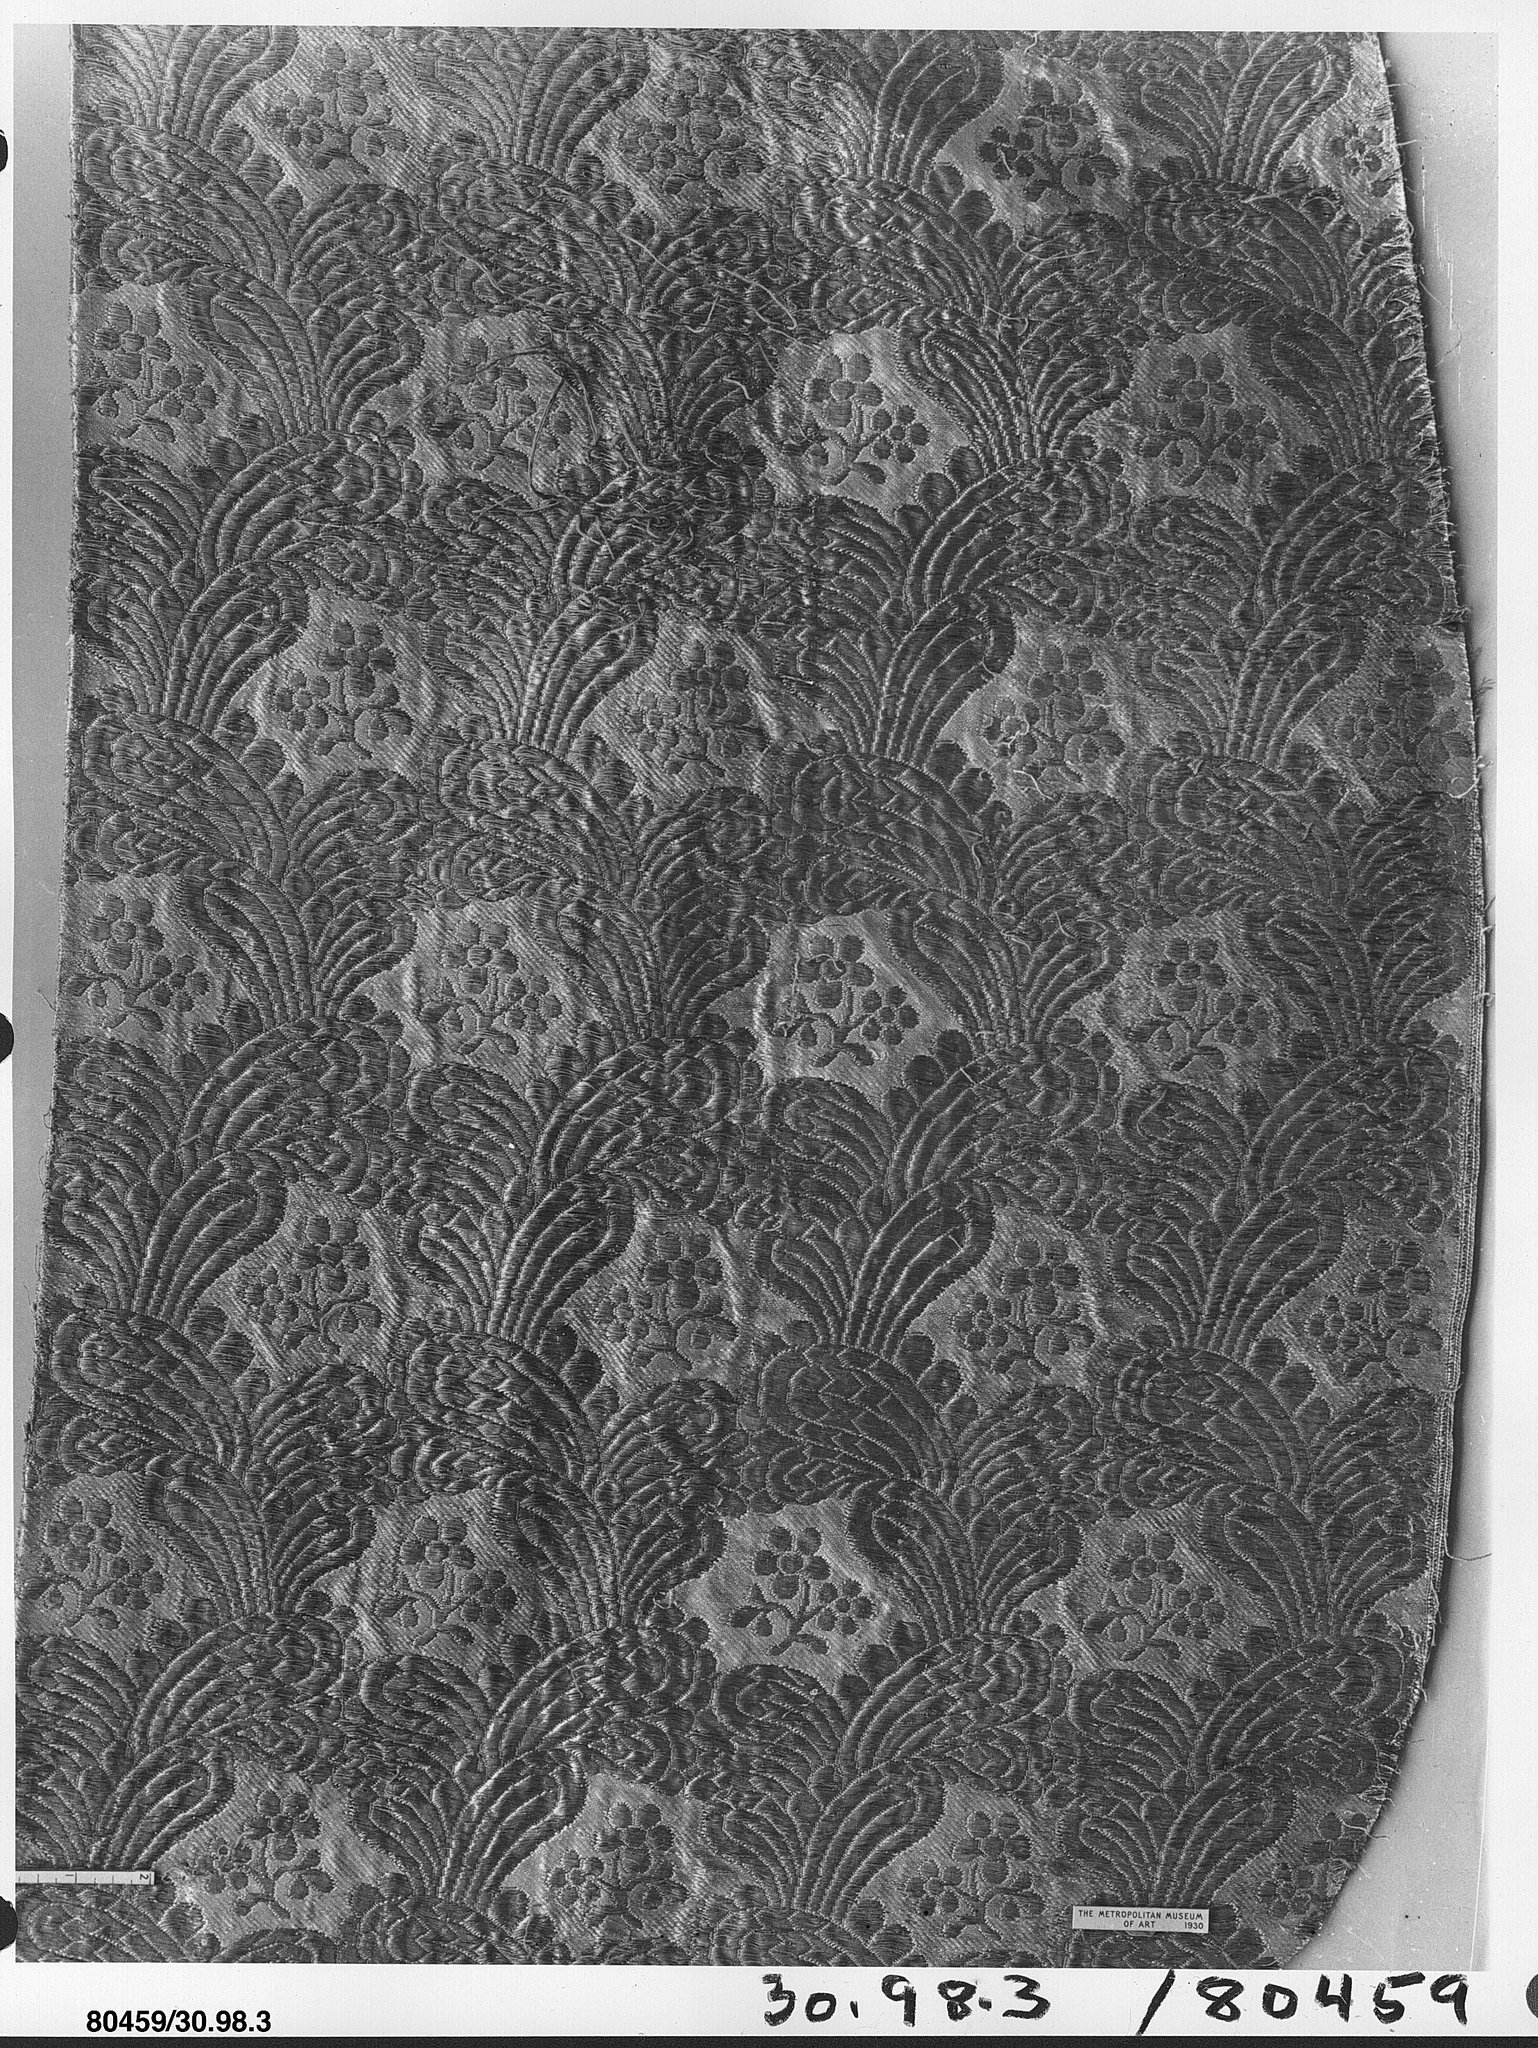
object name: piece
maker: lazareff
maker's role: manufactory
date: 1701-1800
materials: metal thread, silk